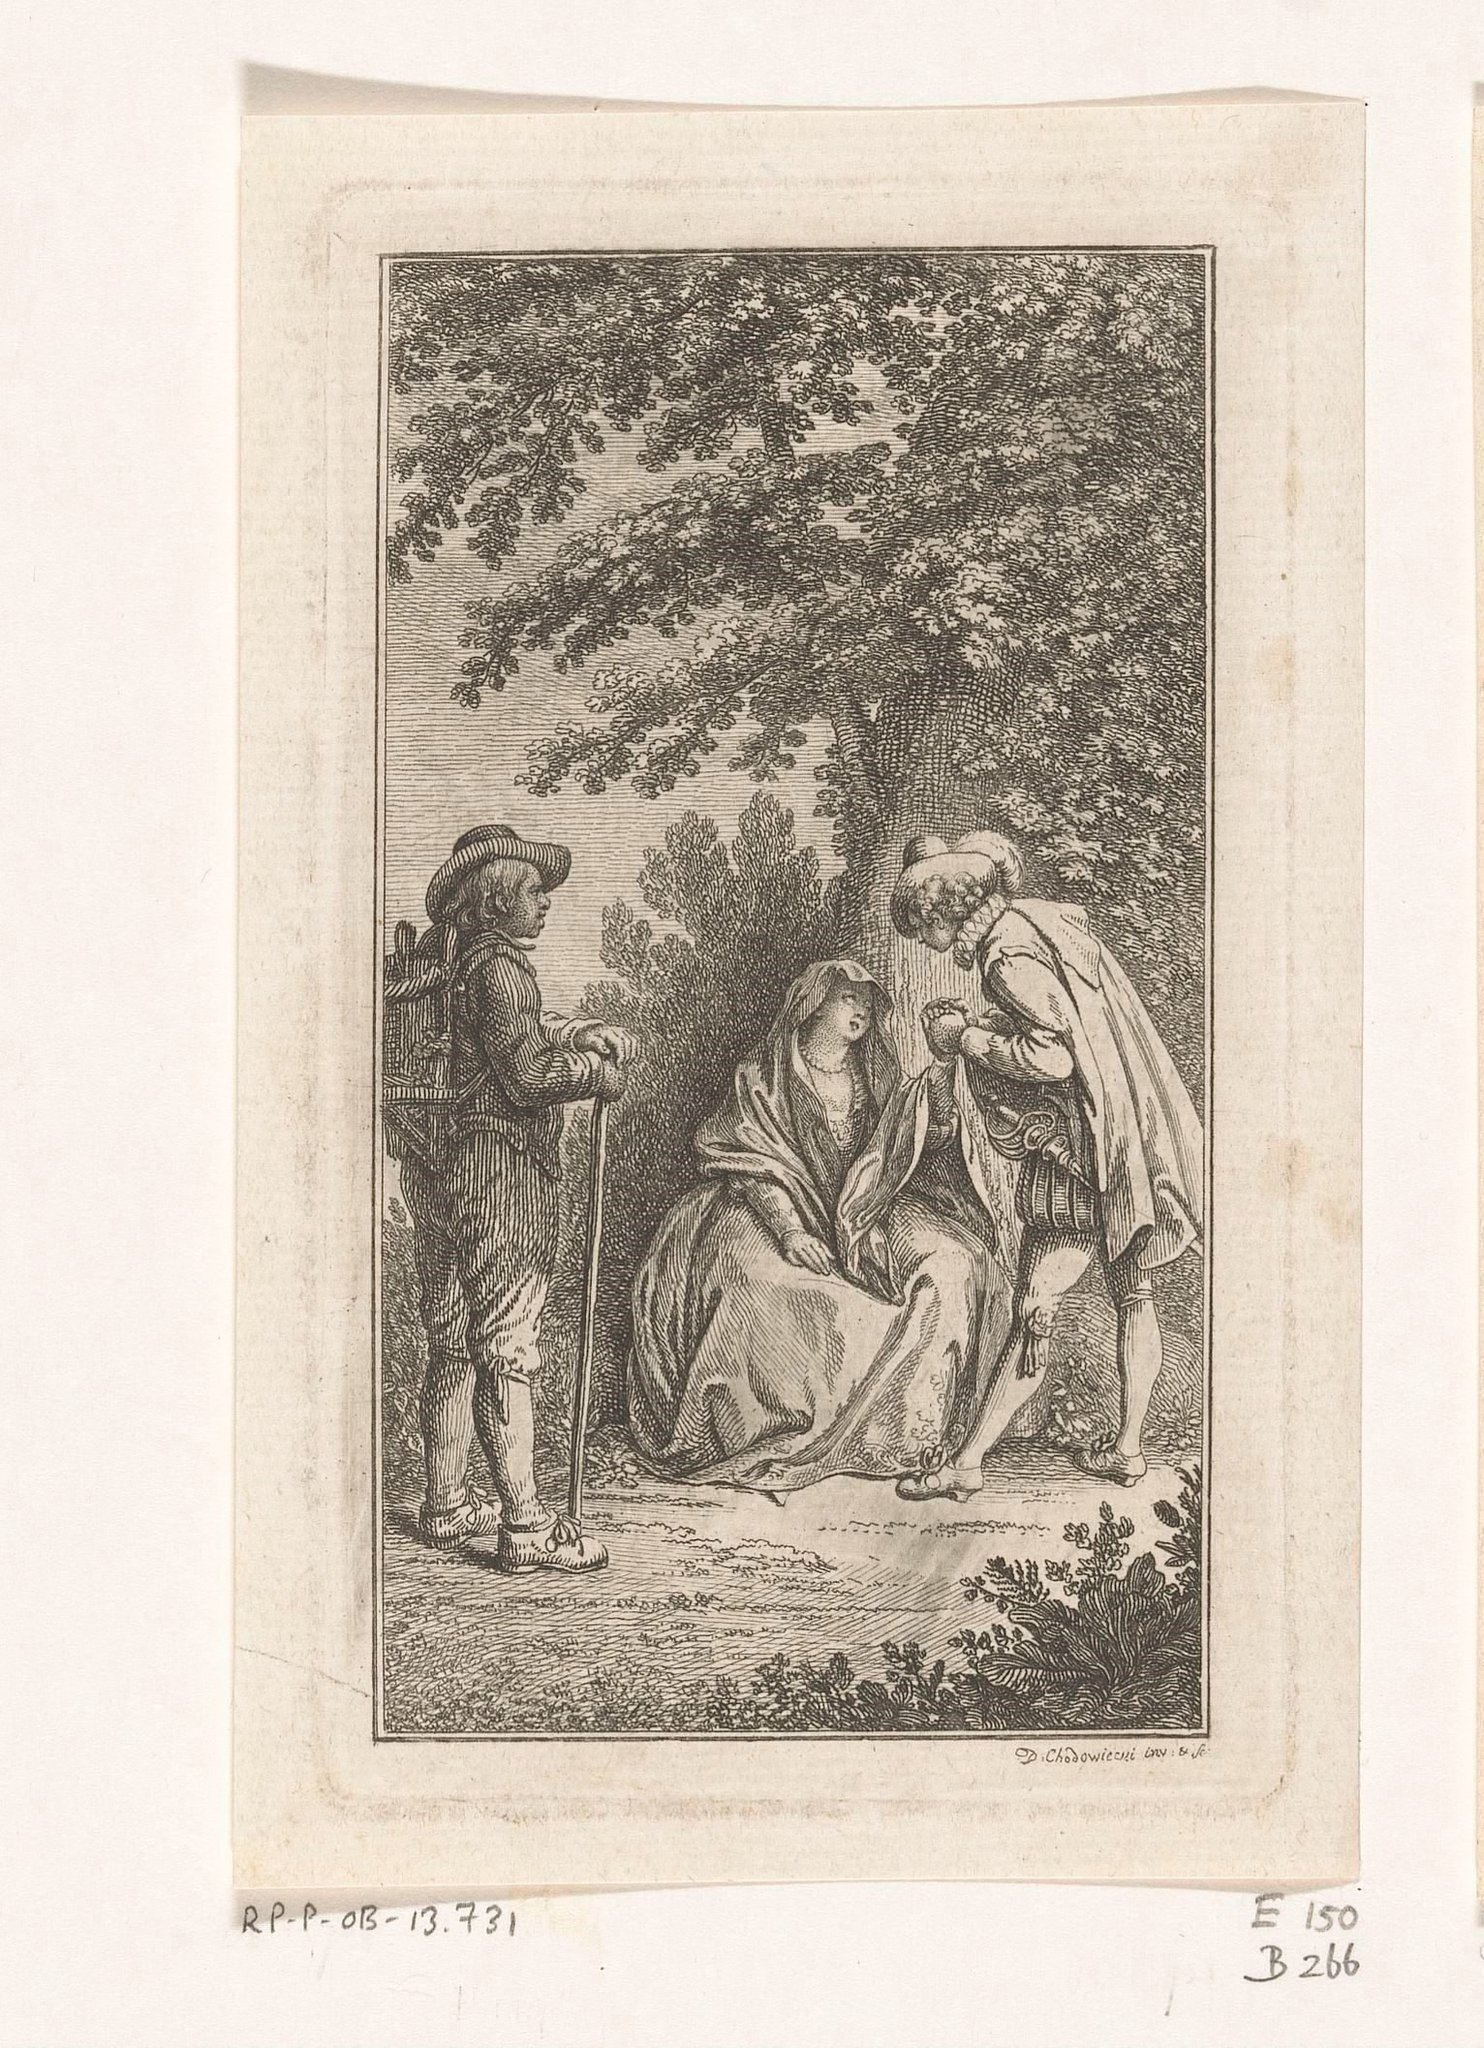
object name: print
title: Bianca Cappello en Pietro Bonaventuri op de vlucht uit Venetië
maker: daniel nikolaus chodowiecki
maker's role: draughtsman, print maker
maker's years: 1726-1801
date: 1776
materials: paper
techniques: etching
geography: berlin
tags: venice, herding, herdsman, herdswoman, shepherd, shepherdess, cowherd, etc., flight, running away; pursuing, couple of lovers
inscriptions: collector's mark: Lugt 2228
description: Scène gebaseerd op het verhaal van Bianca Cappello, een rijke adellijke vrouw die op vijftienjarige leeftijd verliefd werd op de Florentijnse klerk Pietro Bonaventuri. In 1563 vluchtte het jonge stel van Venetië naar Florence, waar ze trouwden. Bianca Cappello zit onder een boom terwijl Pietro Bonaventuri haar hand vasthoudt. Op de voorgrond staat een herder die Bianca een deel van de reis op zijn rug heeft gedragen.